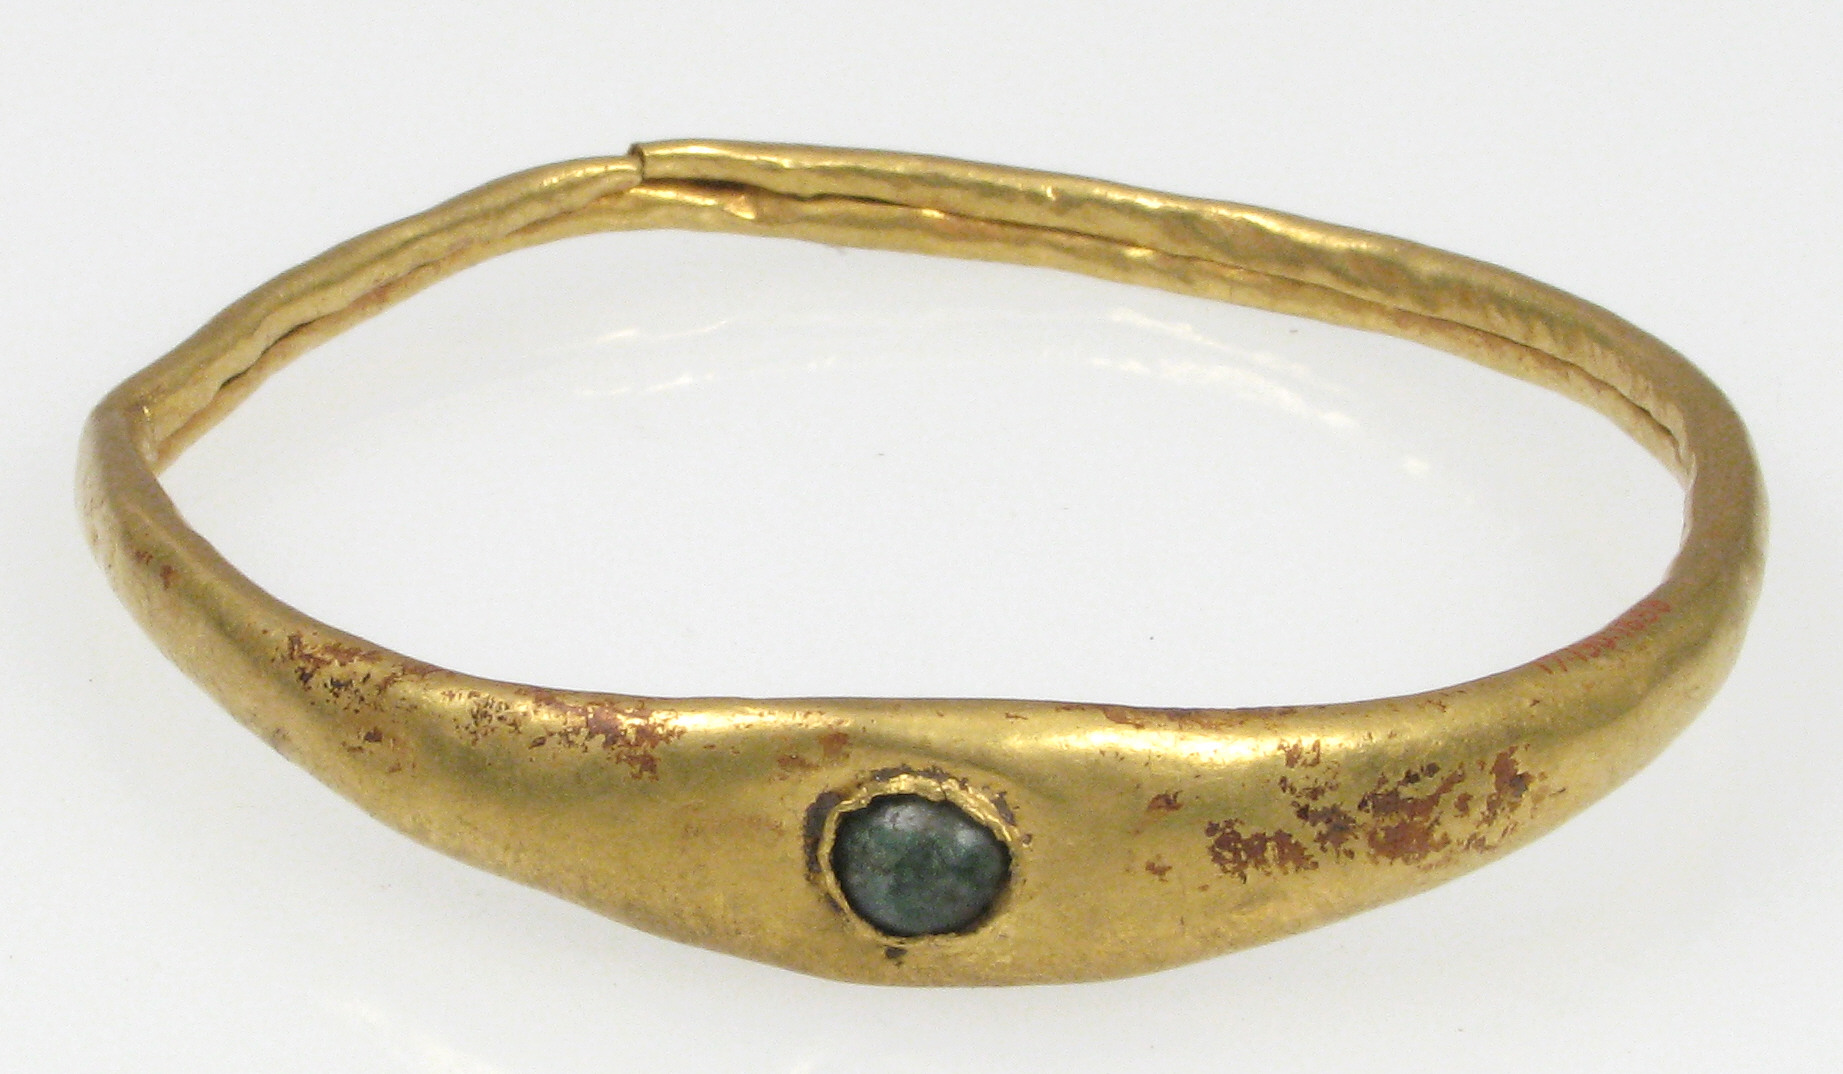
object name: bracelet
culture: roman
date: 100-300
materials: glass, gold, stone